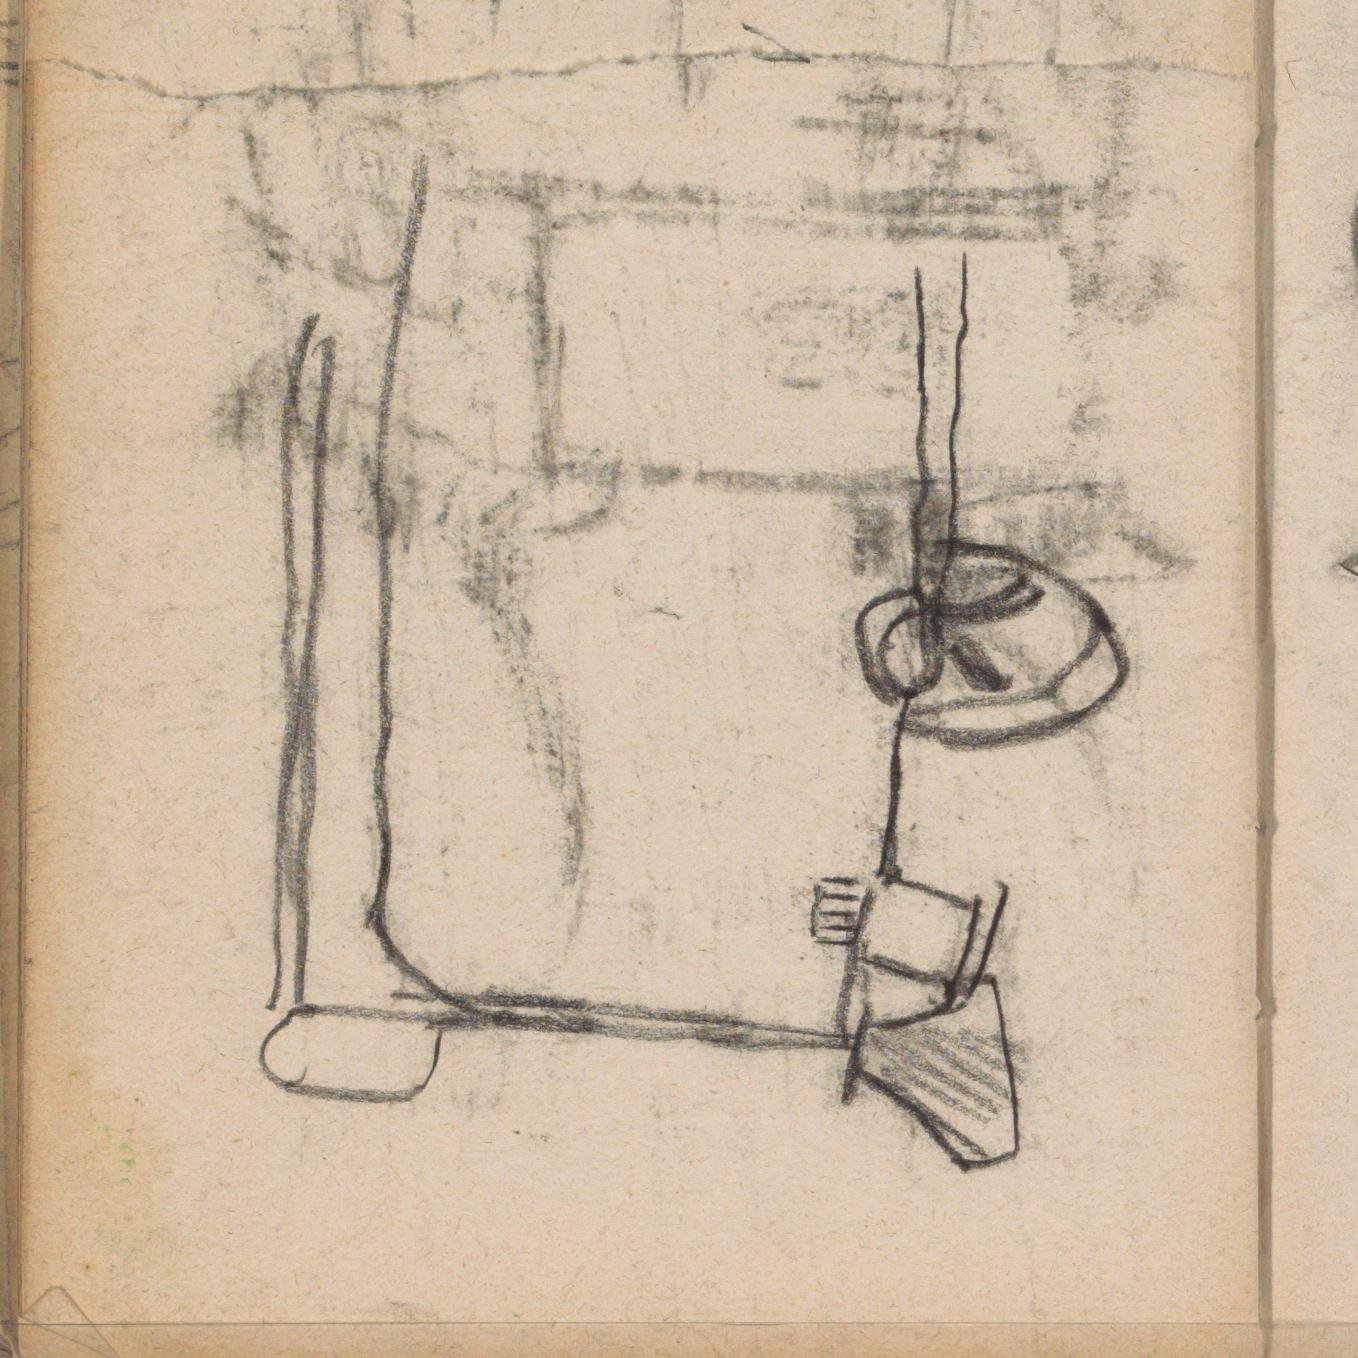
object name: sketchbook leaf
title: Kar of tram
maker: george hendrik breitner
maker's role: draughtsman, painter, print maker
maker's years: 1857-1923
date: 1900-1901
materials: chalk, paper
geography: amsterdam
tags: diligence, omnibus, horse-tram, (farm) wagon, freight wagon, cart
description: Kar of tram. Pagina 45 uit een schetsboek met 46 bladen vervaardigd te Amsterdam.